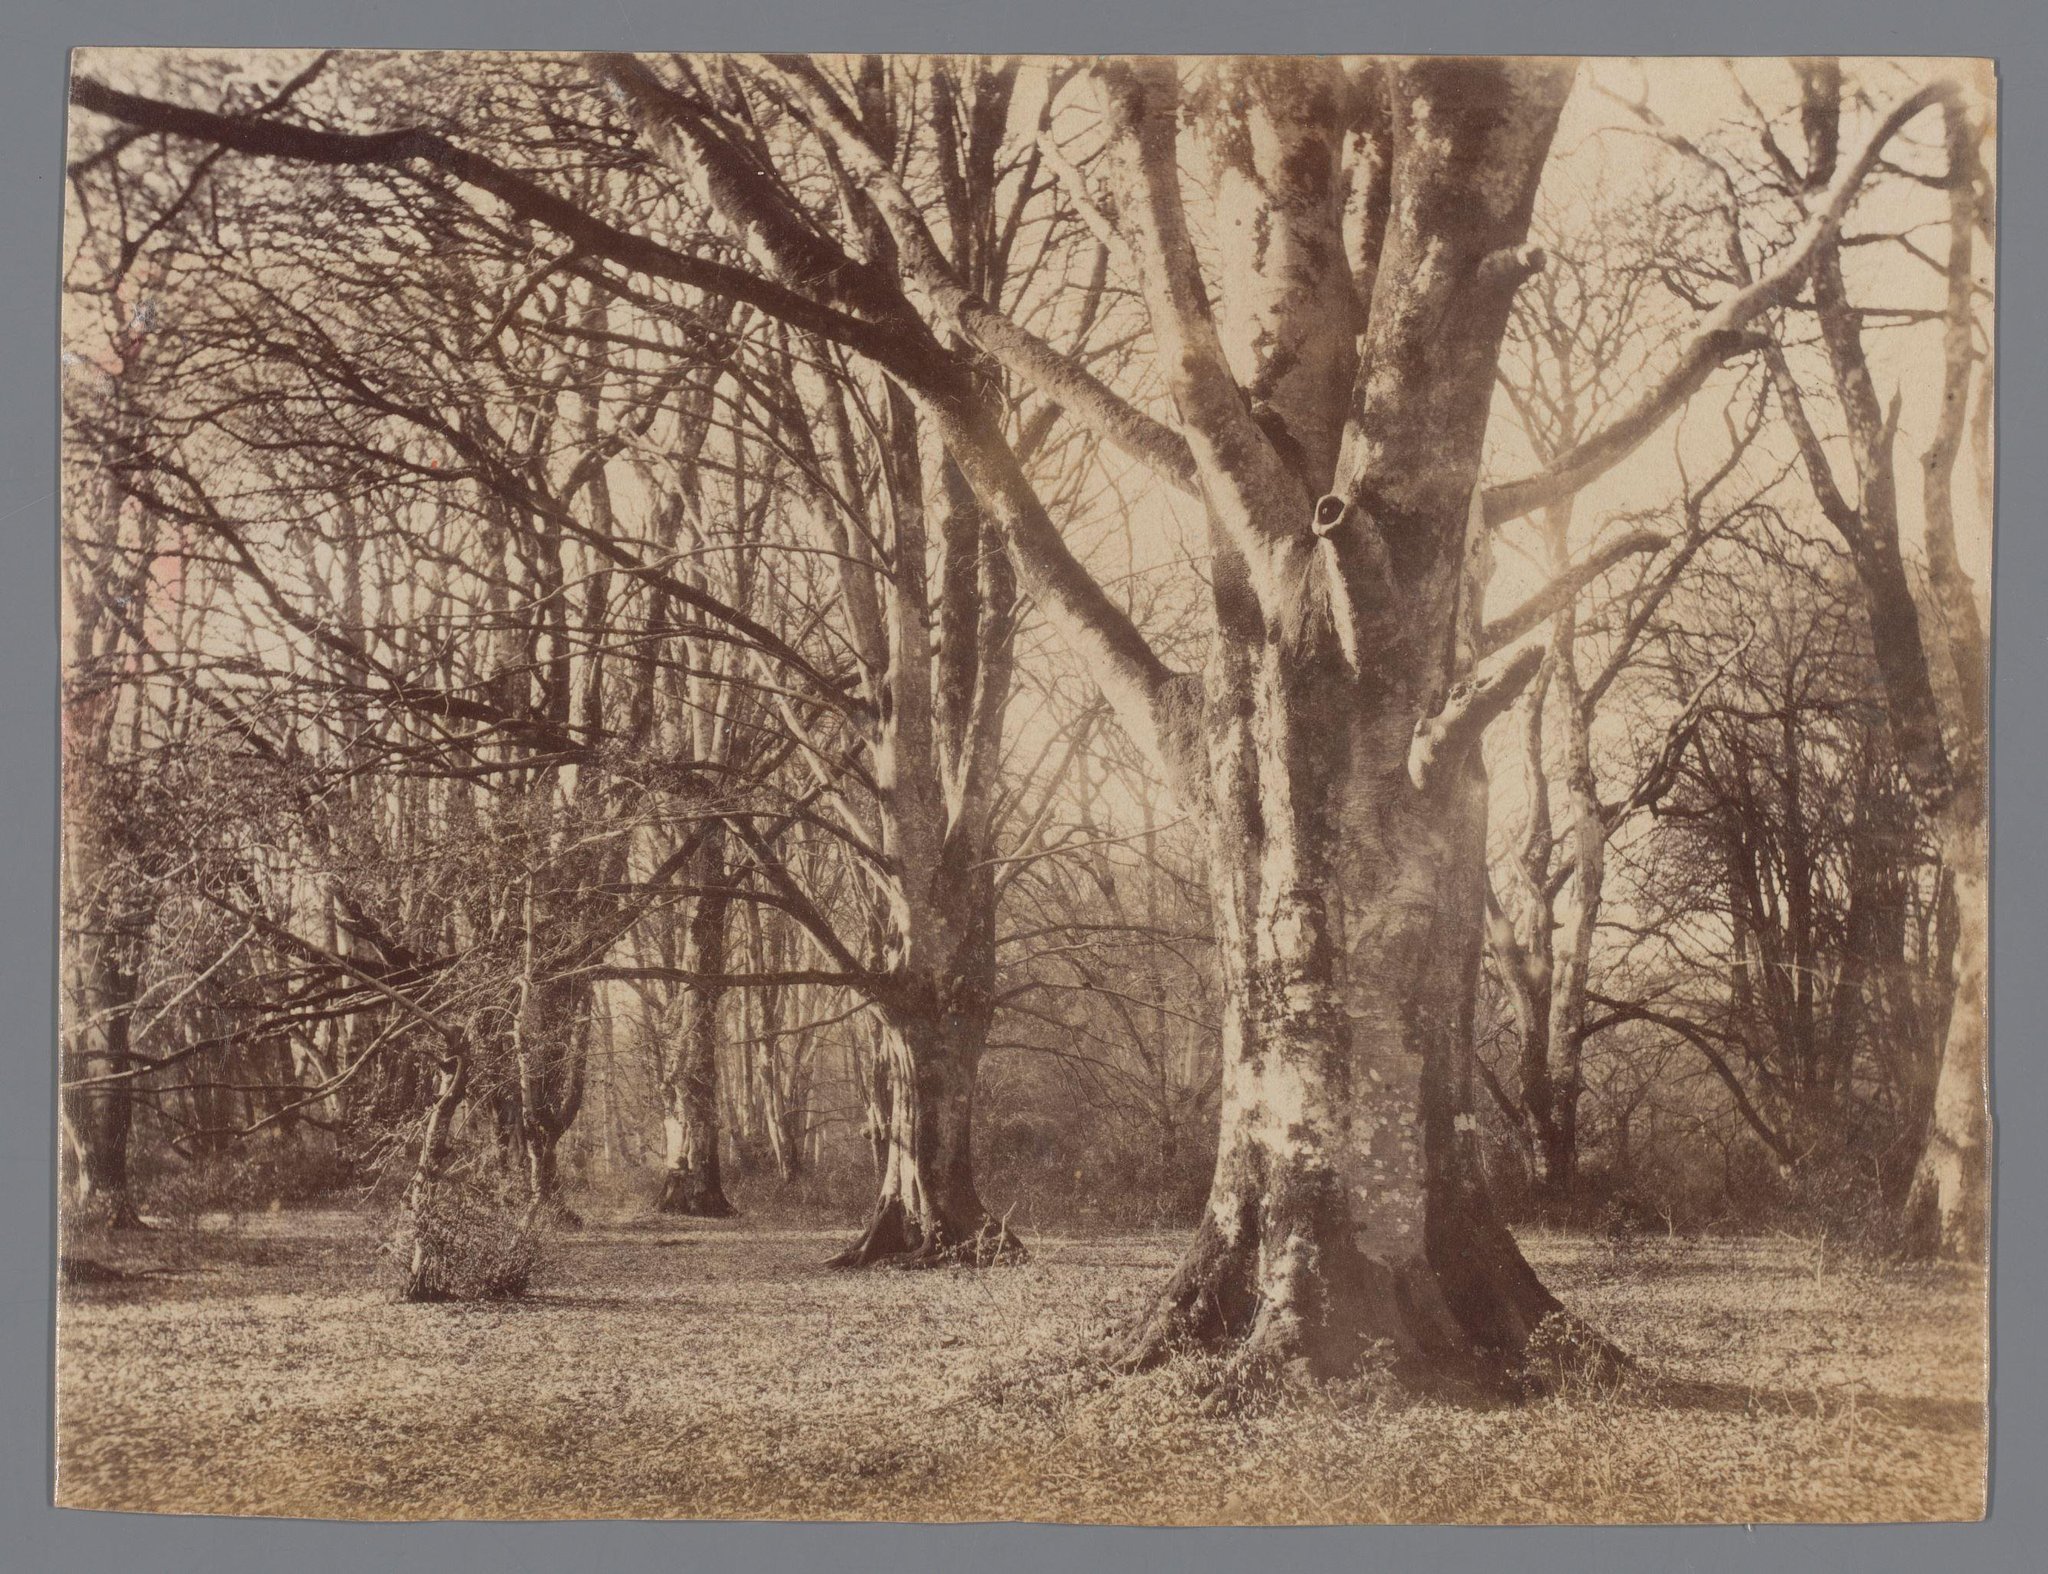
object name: photograph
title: Gezicht op kale bomen in een bos of park in de herfst of winter, Morte Ash (?)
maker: Anonymous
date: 1875-1900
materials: paper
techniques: albumen print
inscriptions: inscription: ‘Wab’, inscription: ‘Monte Ash. of Ark’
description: Gezicht op kale bomen in een bos of park in de herfst of winter. Voor een open plaats, lage zonval van links.